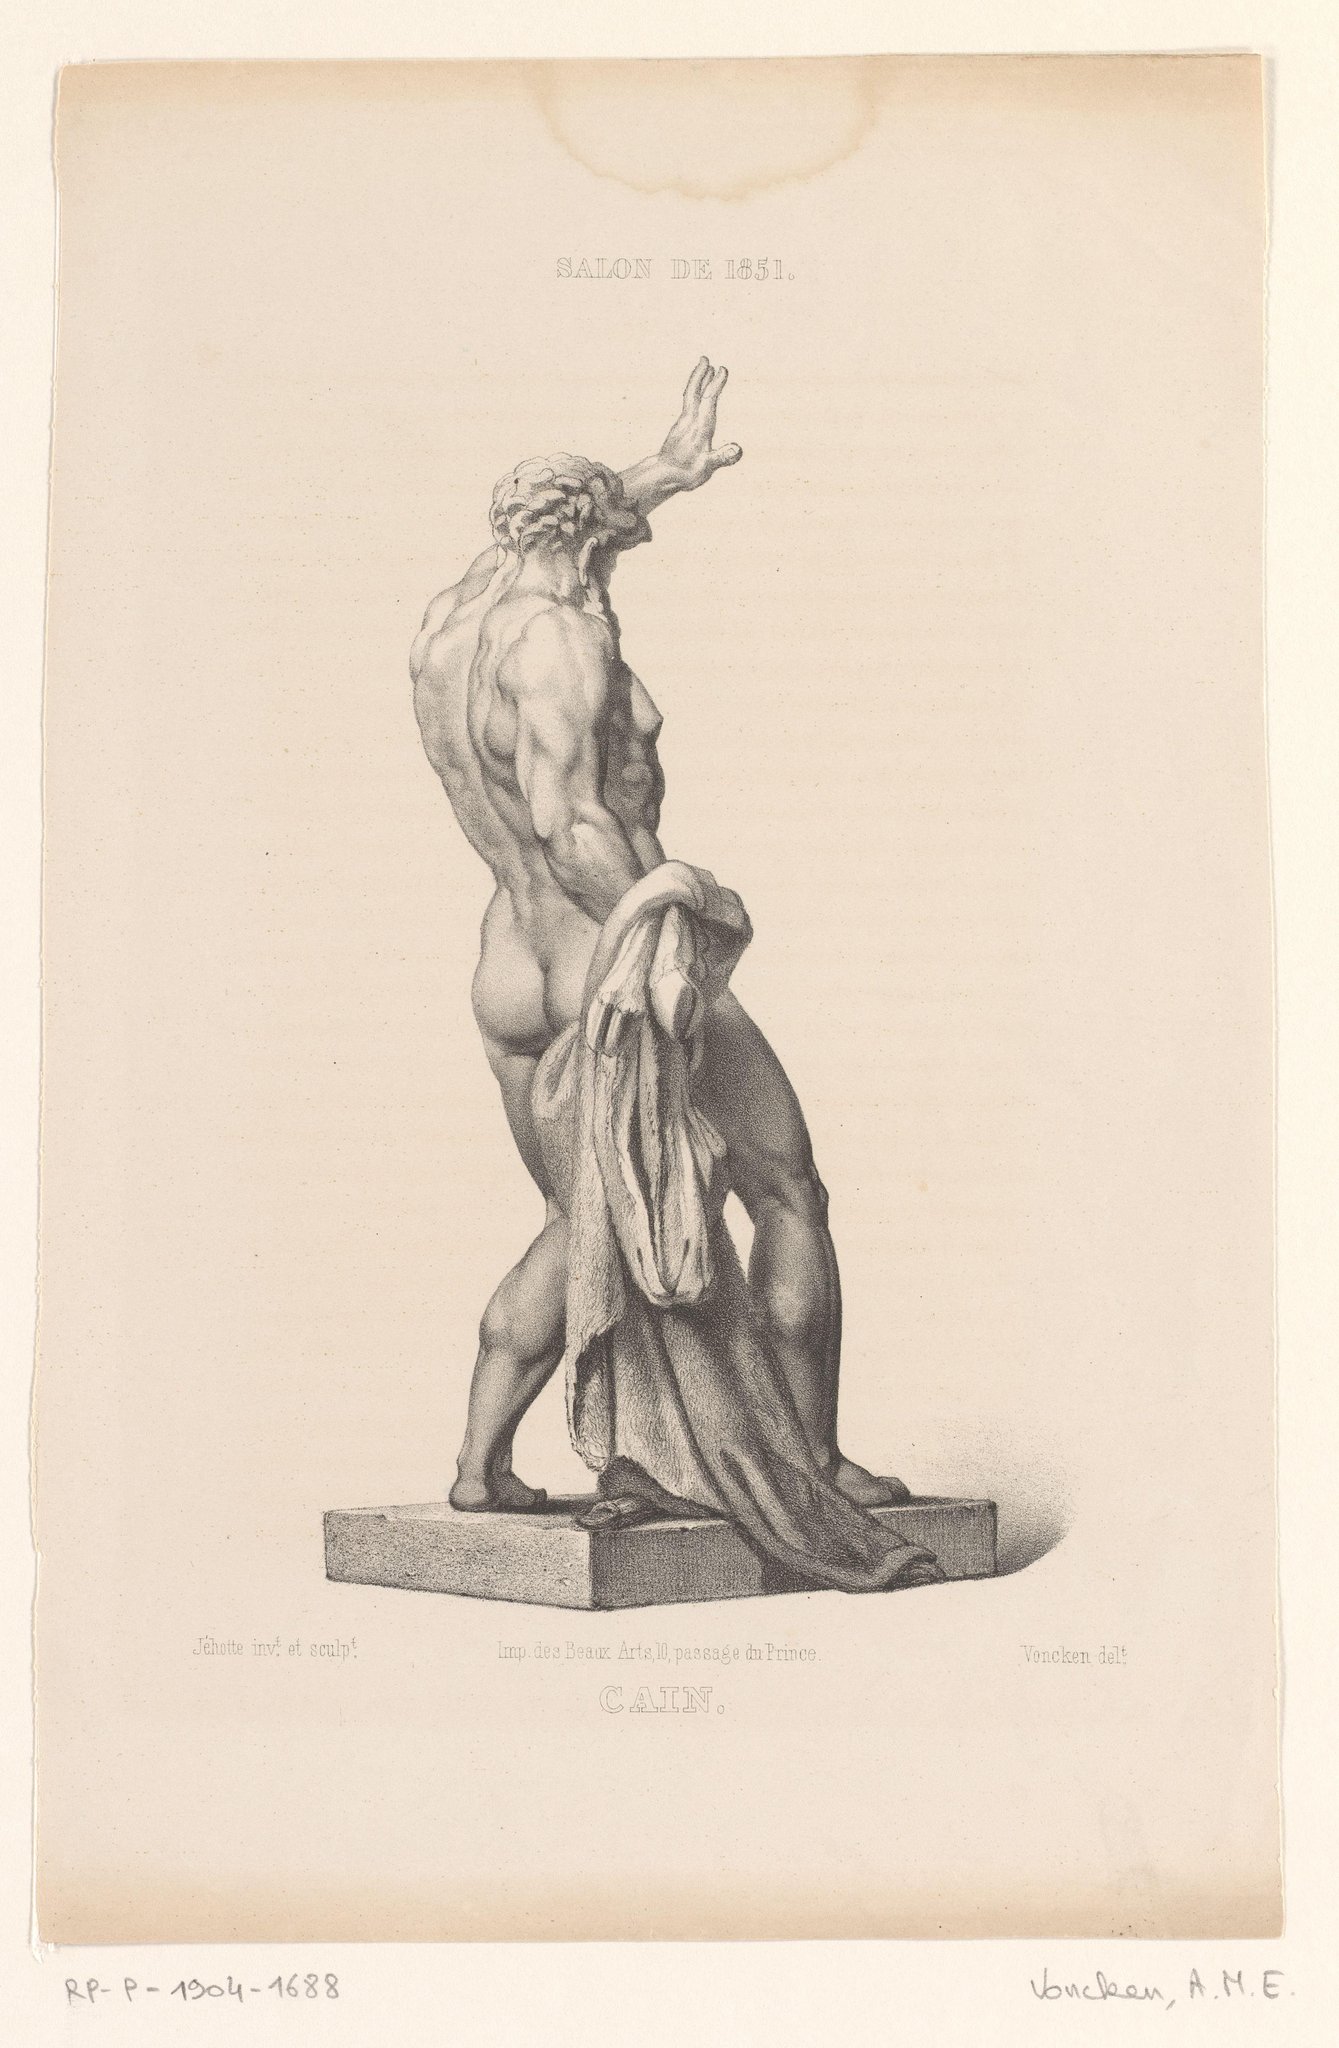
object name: print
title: Beeld van Caïn met opgeheven arm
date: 1851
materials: paper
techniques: lithograph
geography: brussels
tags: sculpture, the story of cain and abel (genesis 4:3-17)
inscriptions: collector's mark: Lugt 2228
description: Het beeld van Louis Jéhotte stond in 1851 op de Salon van Brussel.